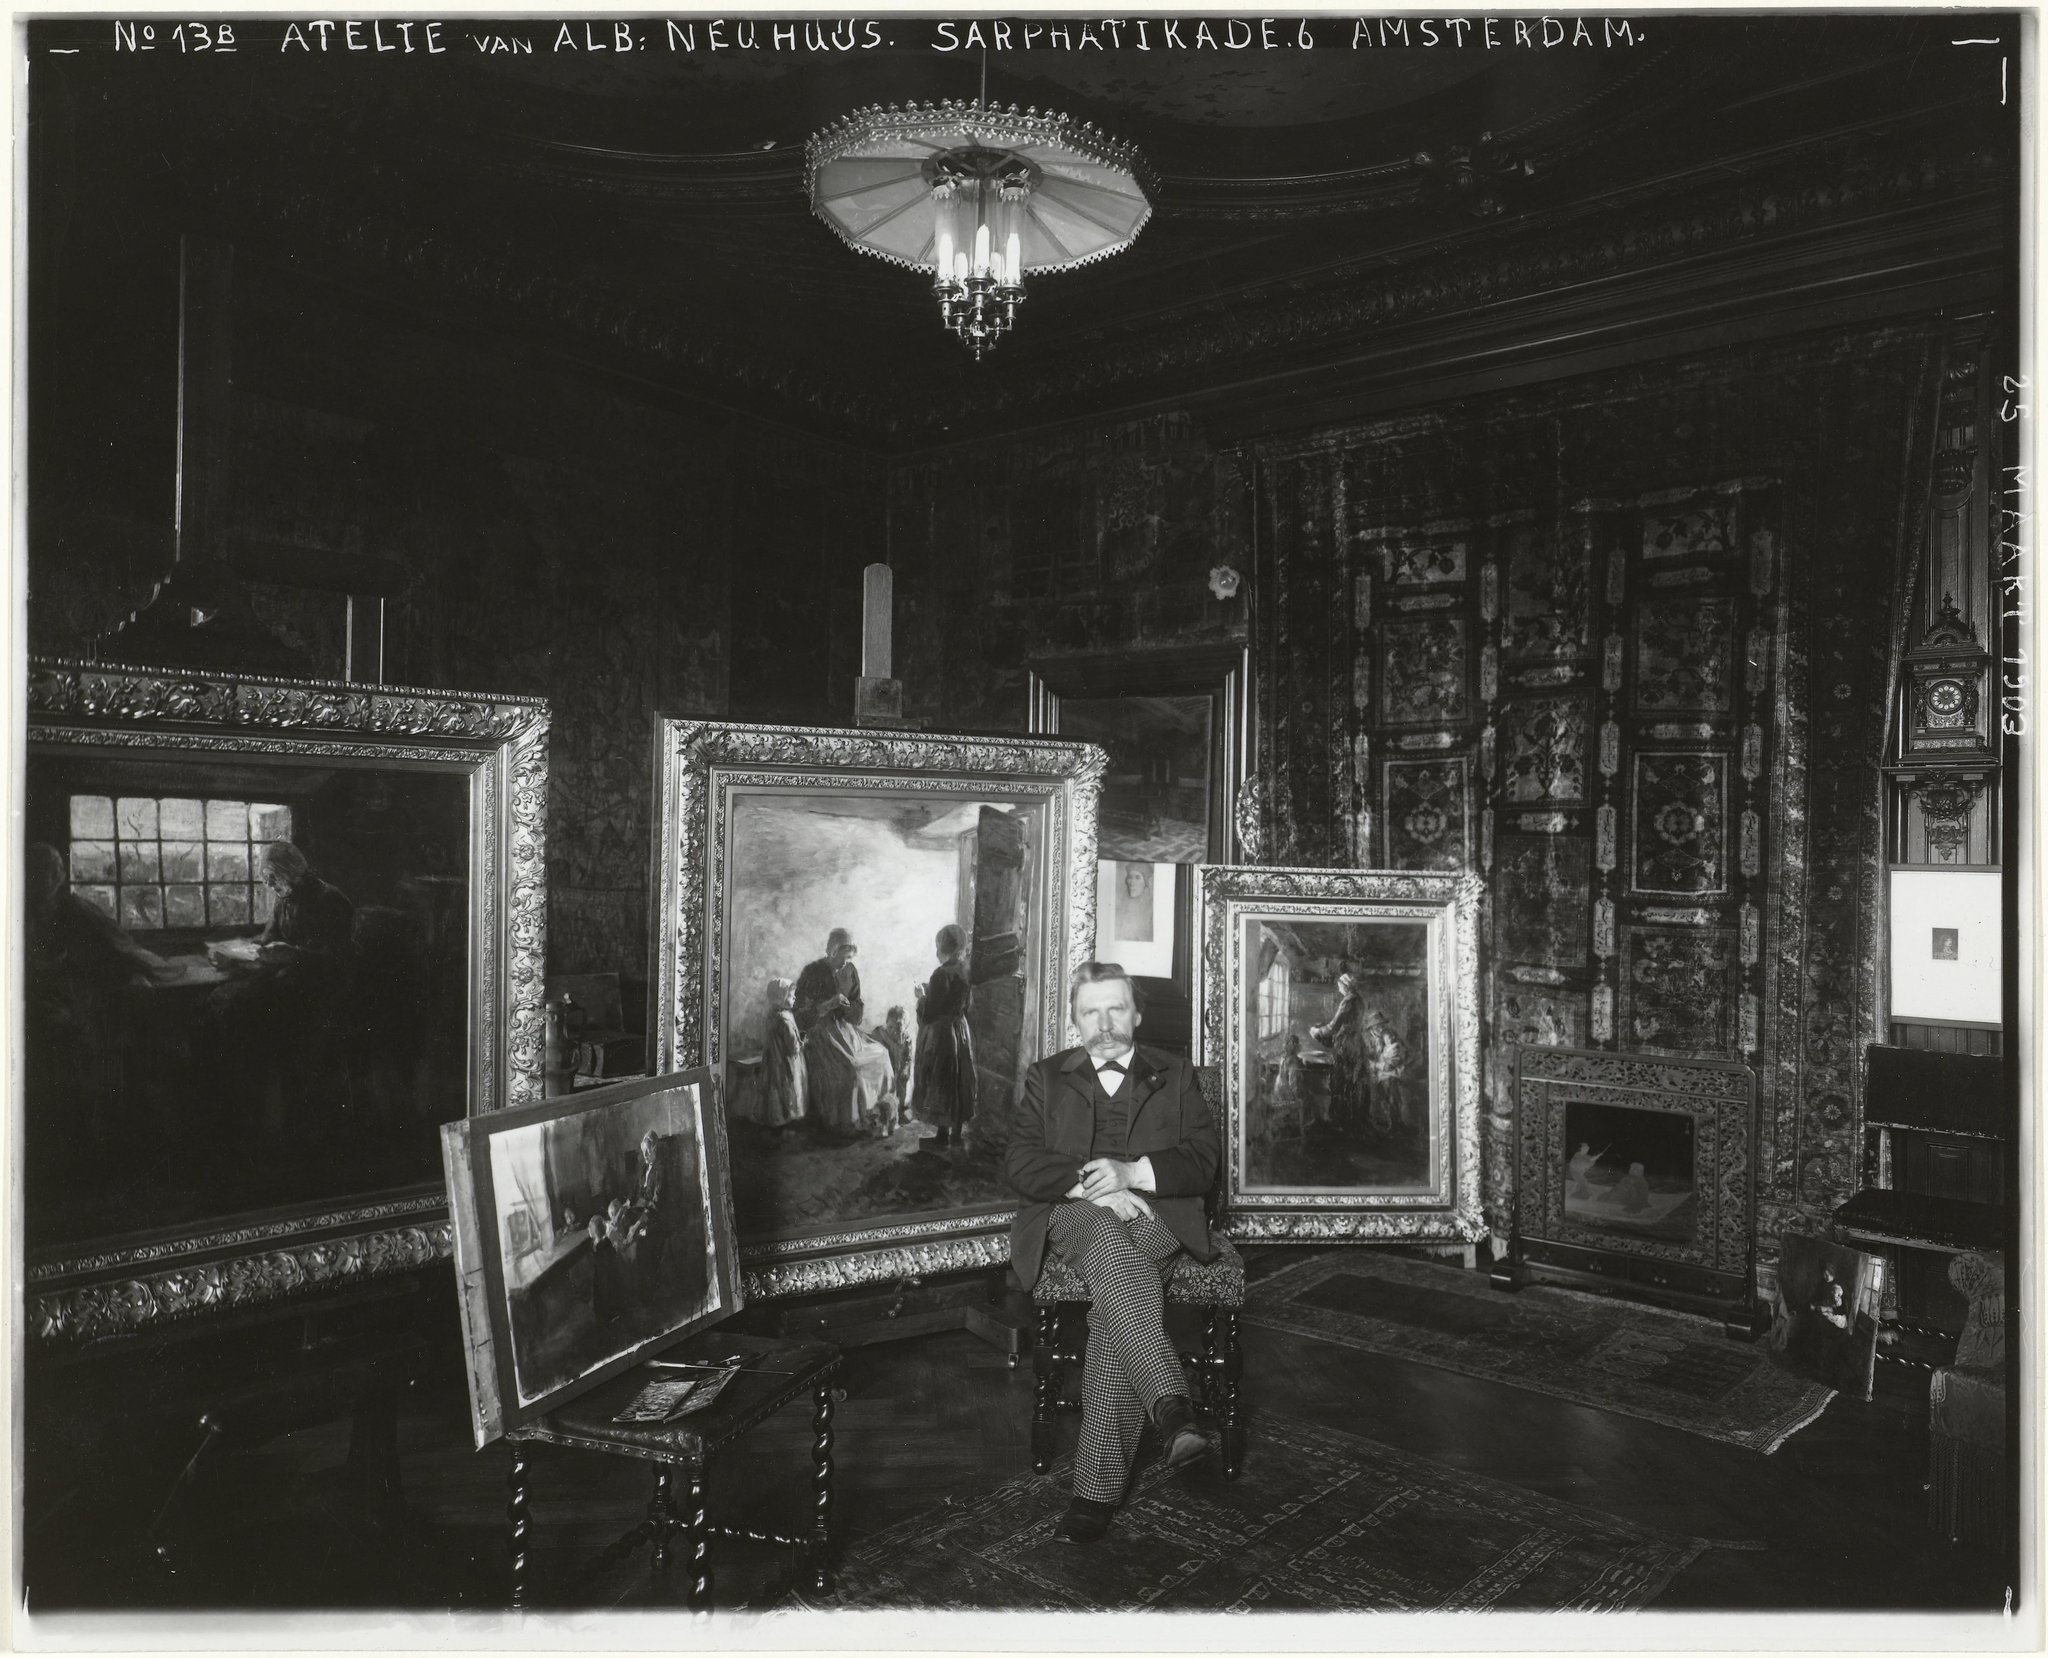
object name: photograph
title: Albert Neuhuys in zijn atelier aan de Sarphatikade 6 in Amsterdam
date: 1903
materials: paper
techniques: gelatin silver print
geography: amsterdam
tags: draughtsman, albert neuhuys (1844-1914), painter at work, in his studio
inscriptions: inscription: ‘No 13B ATELIE VAN ALB: NEUHUIJS SARPHATIKADE 6 AMSTERDAM/ 23 MAART 1903’